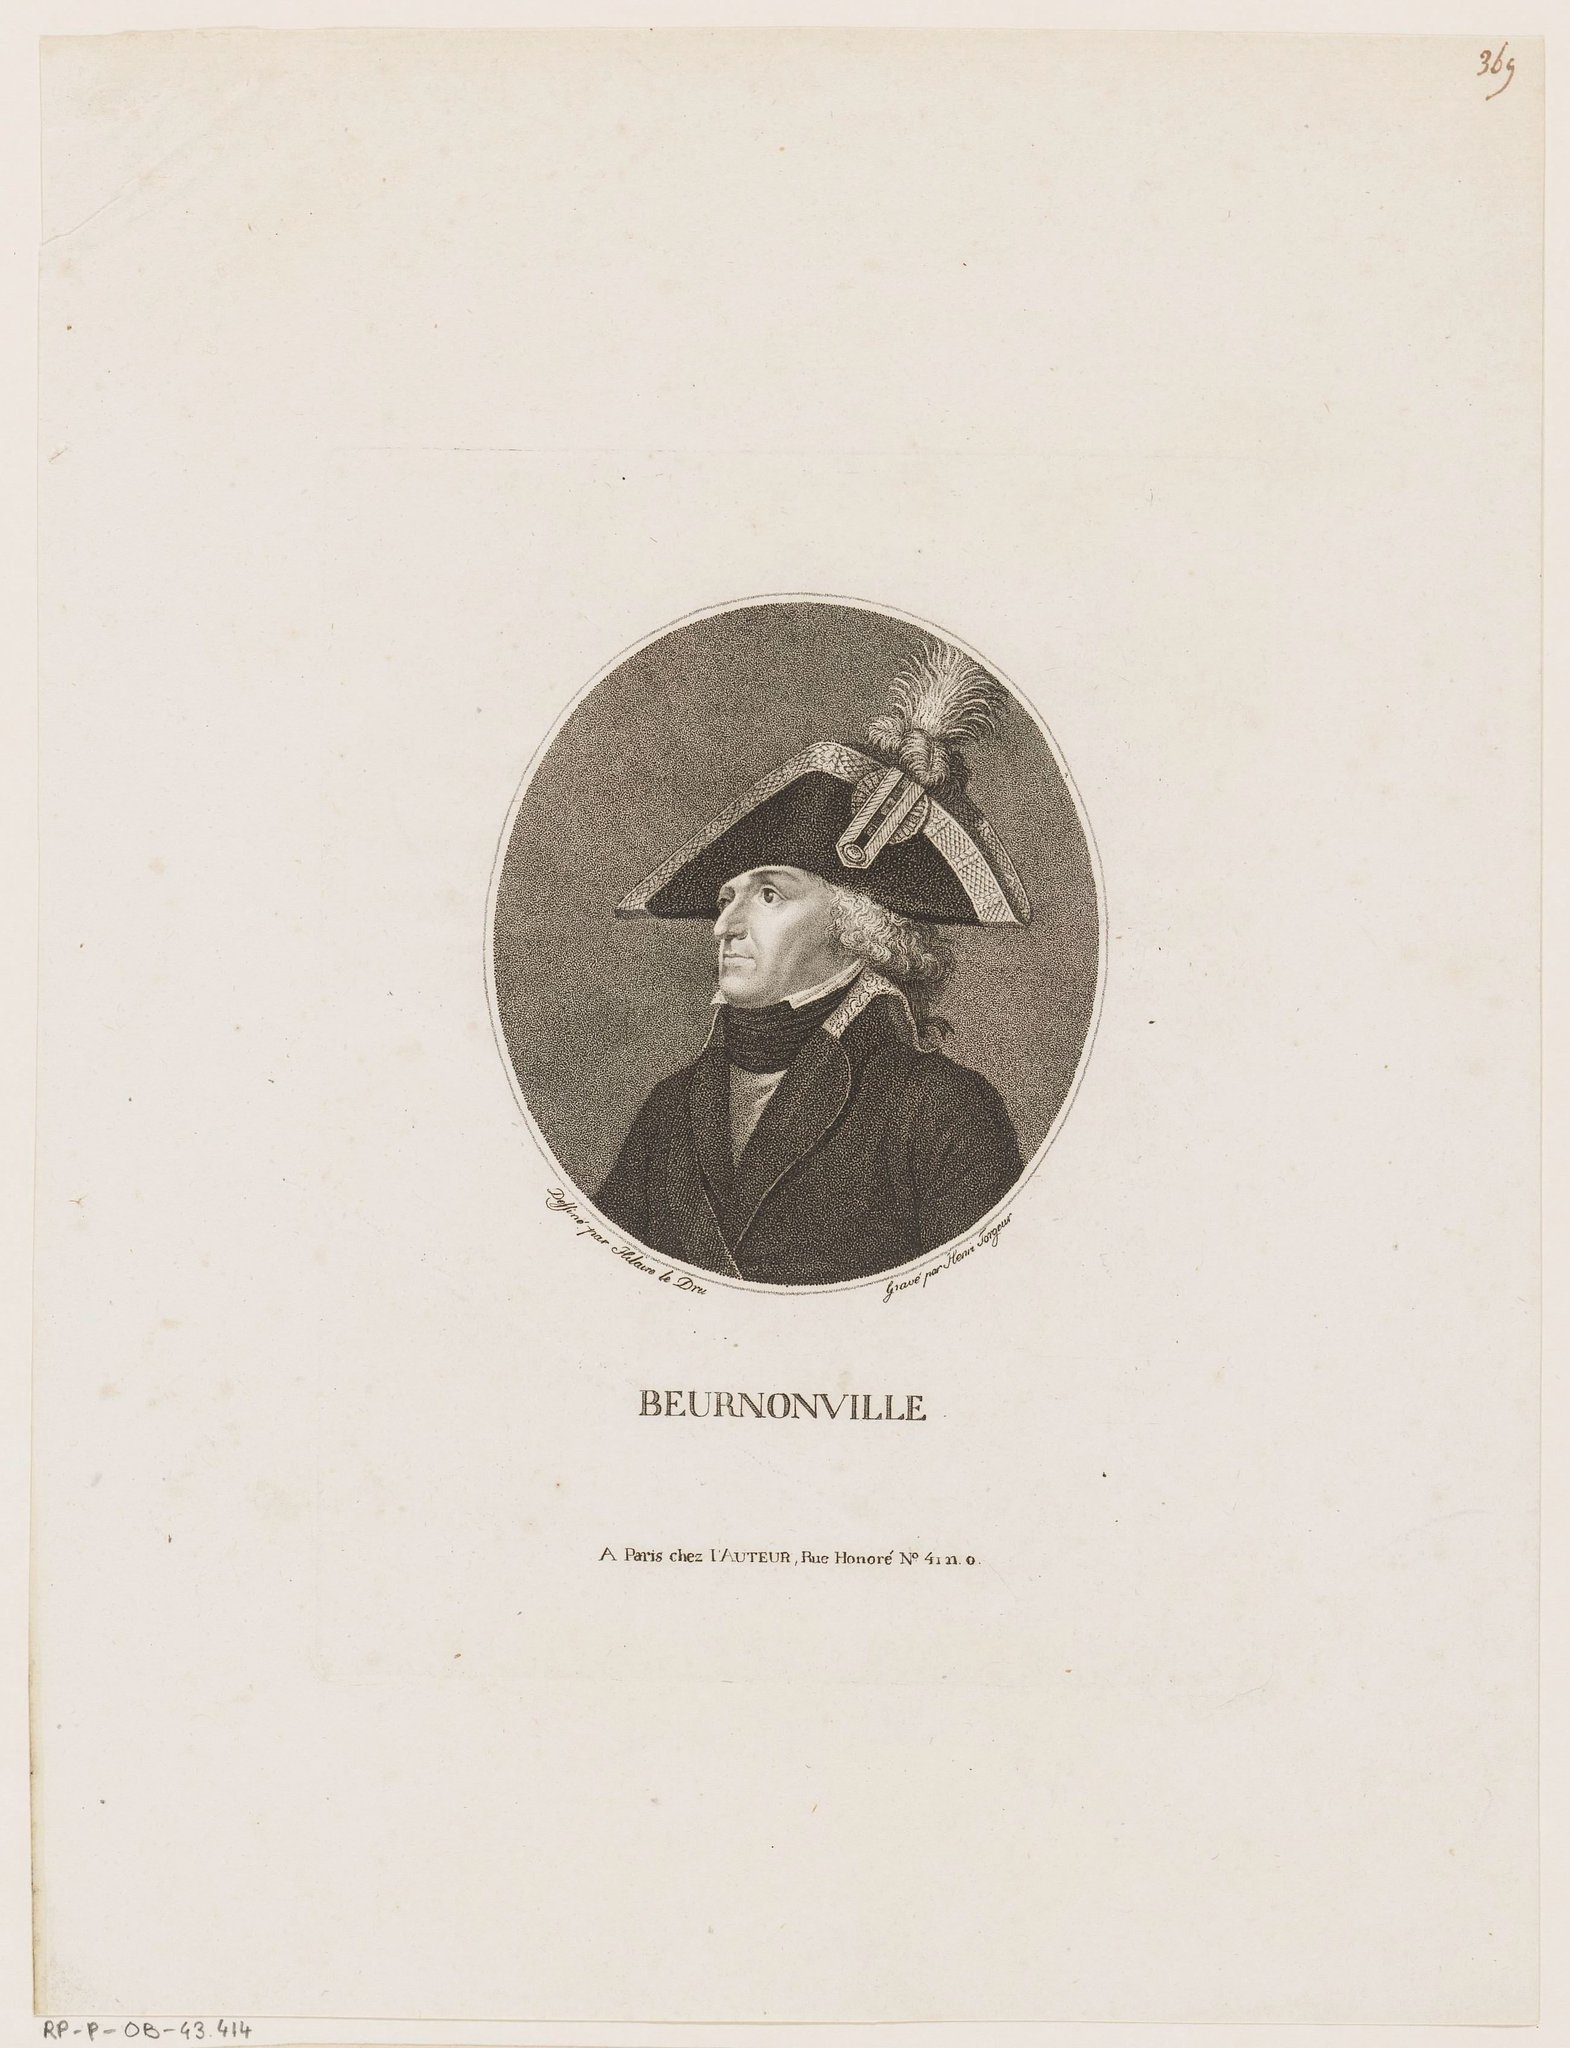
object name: print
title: Portret van Pierre de Riël de Beurnonville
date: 1700-1799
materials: paper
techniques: engraving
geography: paris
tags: paris, commander-in-chief, general, marshal, historical persons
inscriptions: collector's mark: Lugt 2228, number: ‘369’